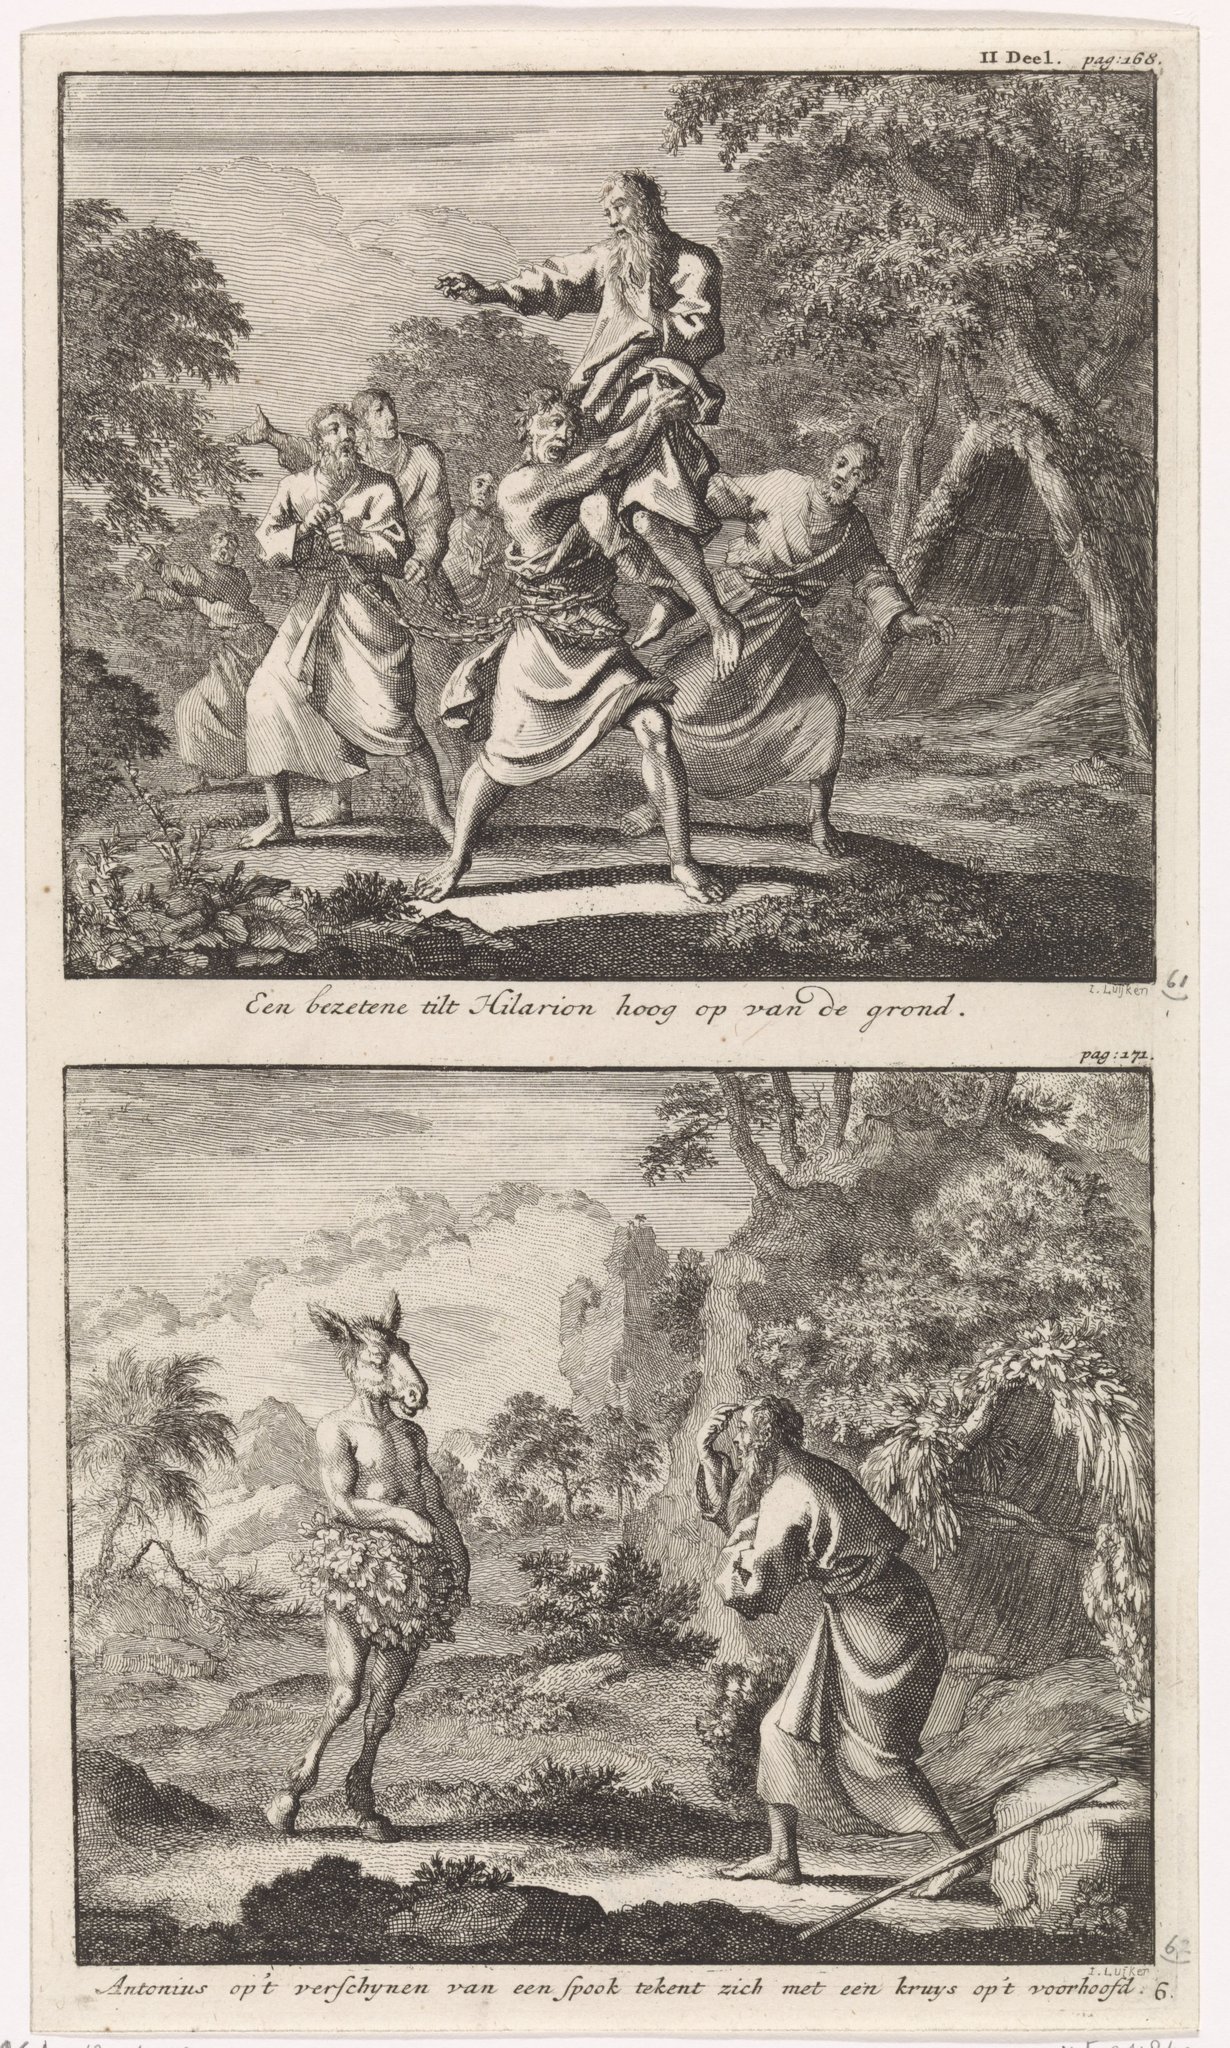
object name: book illustration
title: Een bezetene tilt Hilarion hoog op van de grond / Antonius op't verschynen van een spook tekent zich met een kruys op 't voorhoofd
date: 1701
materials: paper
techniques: etching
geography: amsterdam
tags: the early christian churches, e.g. armenians, copts, syrians, male saints (with name), monsters with animal head, ass, donkey, possession (by demons), st. antony abbot tormented by devils, attacking him on the ground or carrying him aloft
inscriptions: collector's mark: Lugt 2228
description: Twee voorstellingen op een plaat. Boven: een bezeten man tilt de H. Hilarion op. Rondom hem de geschokte leerlingen van de H. Hilarion. Onder: de Heilige Antonius in de wildernis. Hij maakt een kruisteken bij het zien van een man met de kop en de poten van een ezel.